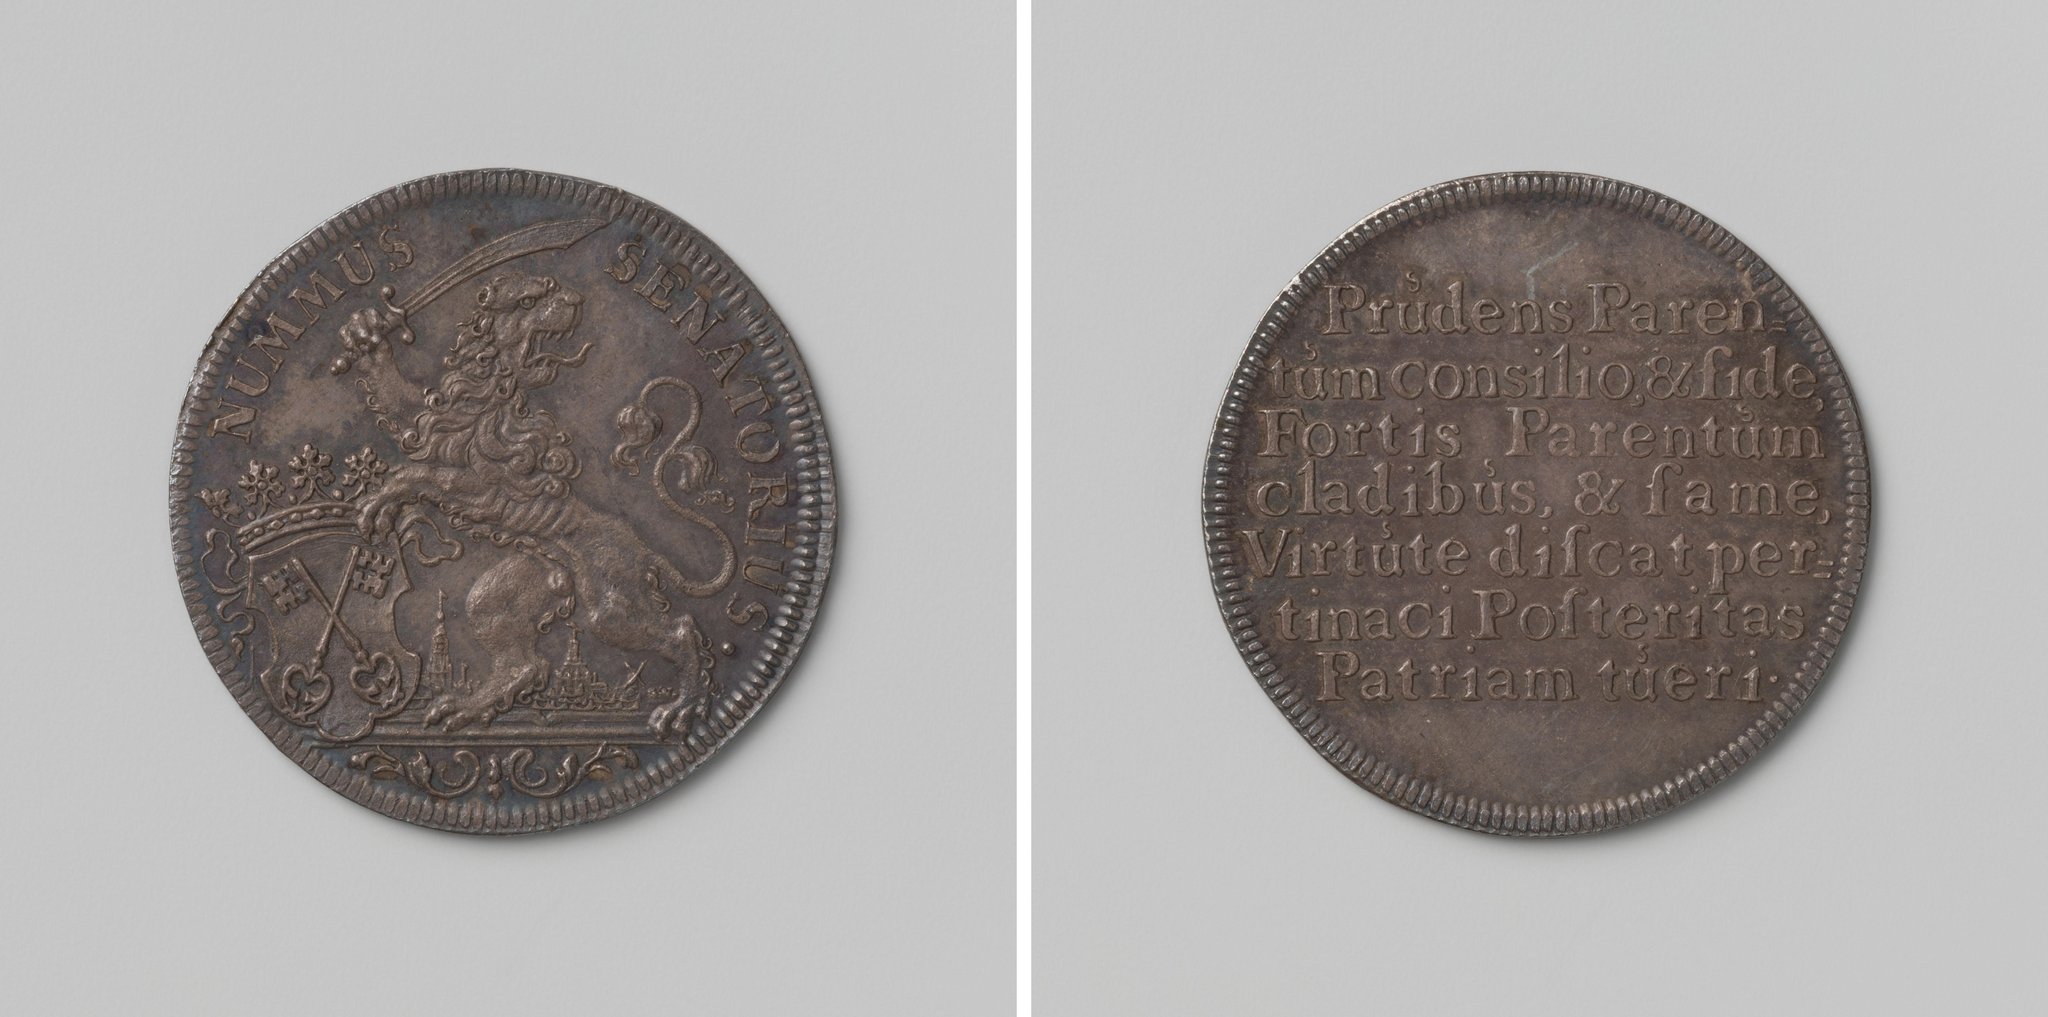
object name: council medal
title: Vroedschapspenning van de stad Leiden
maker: Anonymous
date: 1671-1723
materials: silver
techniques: striking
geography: leiden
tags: leiden